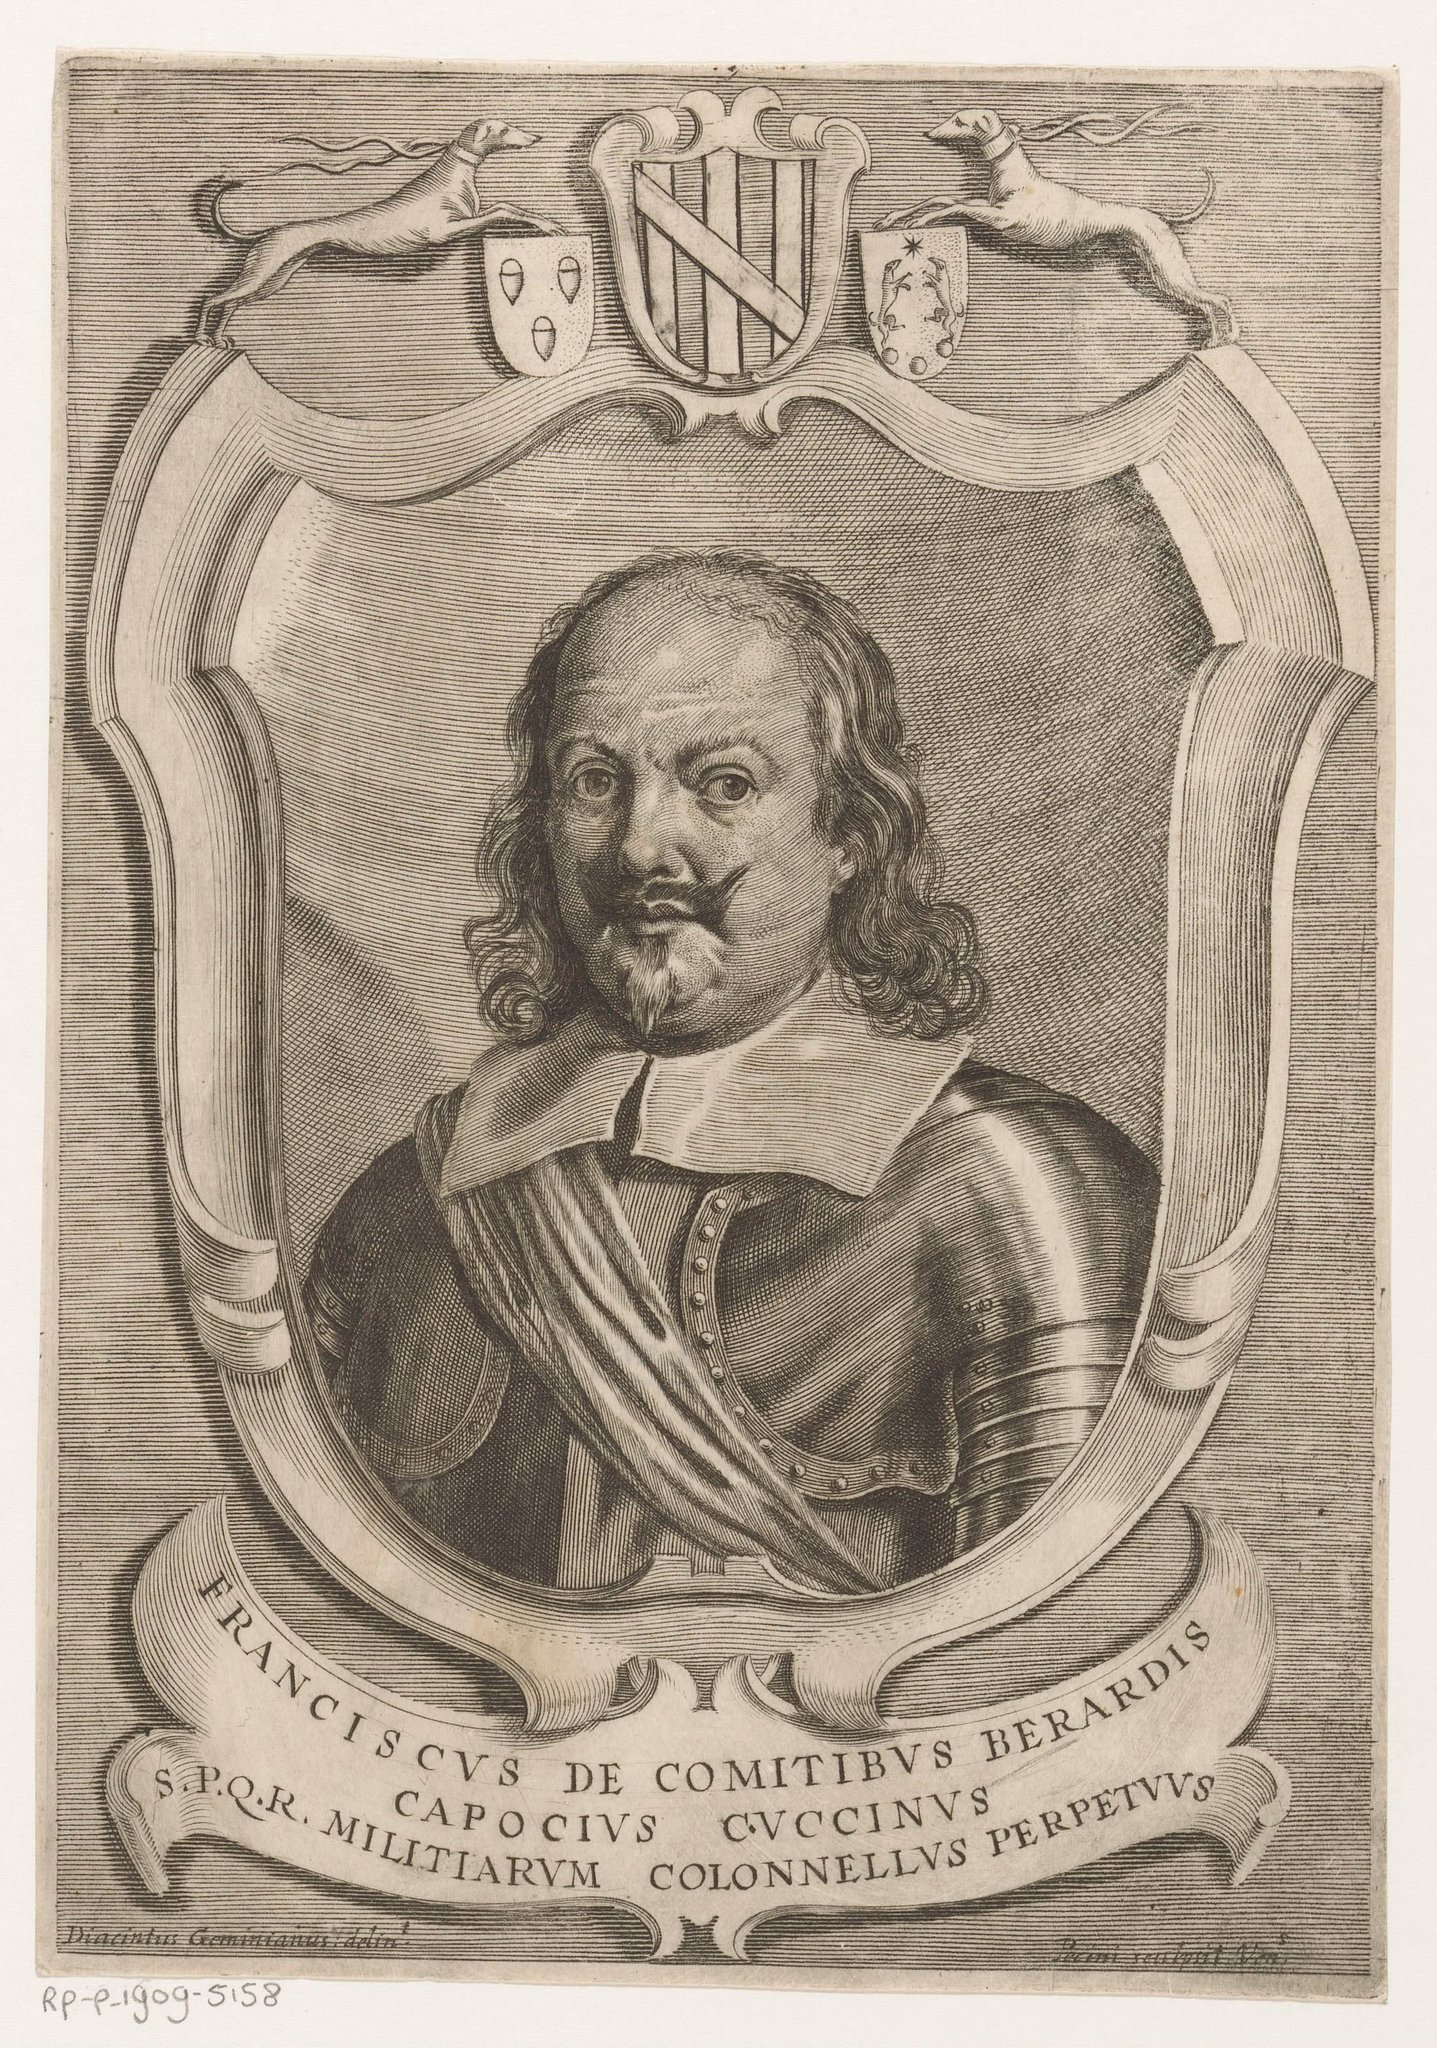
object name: print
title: Portret van Franciscus Berardis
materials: paper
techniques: engraving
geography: italy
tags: historical persons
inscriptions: collector's mark: Lugt 2228